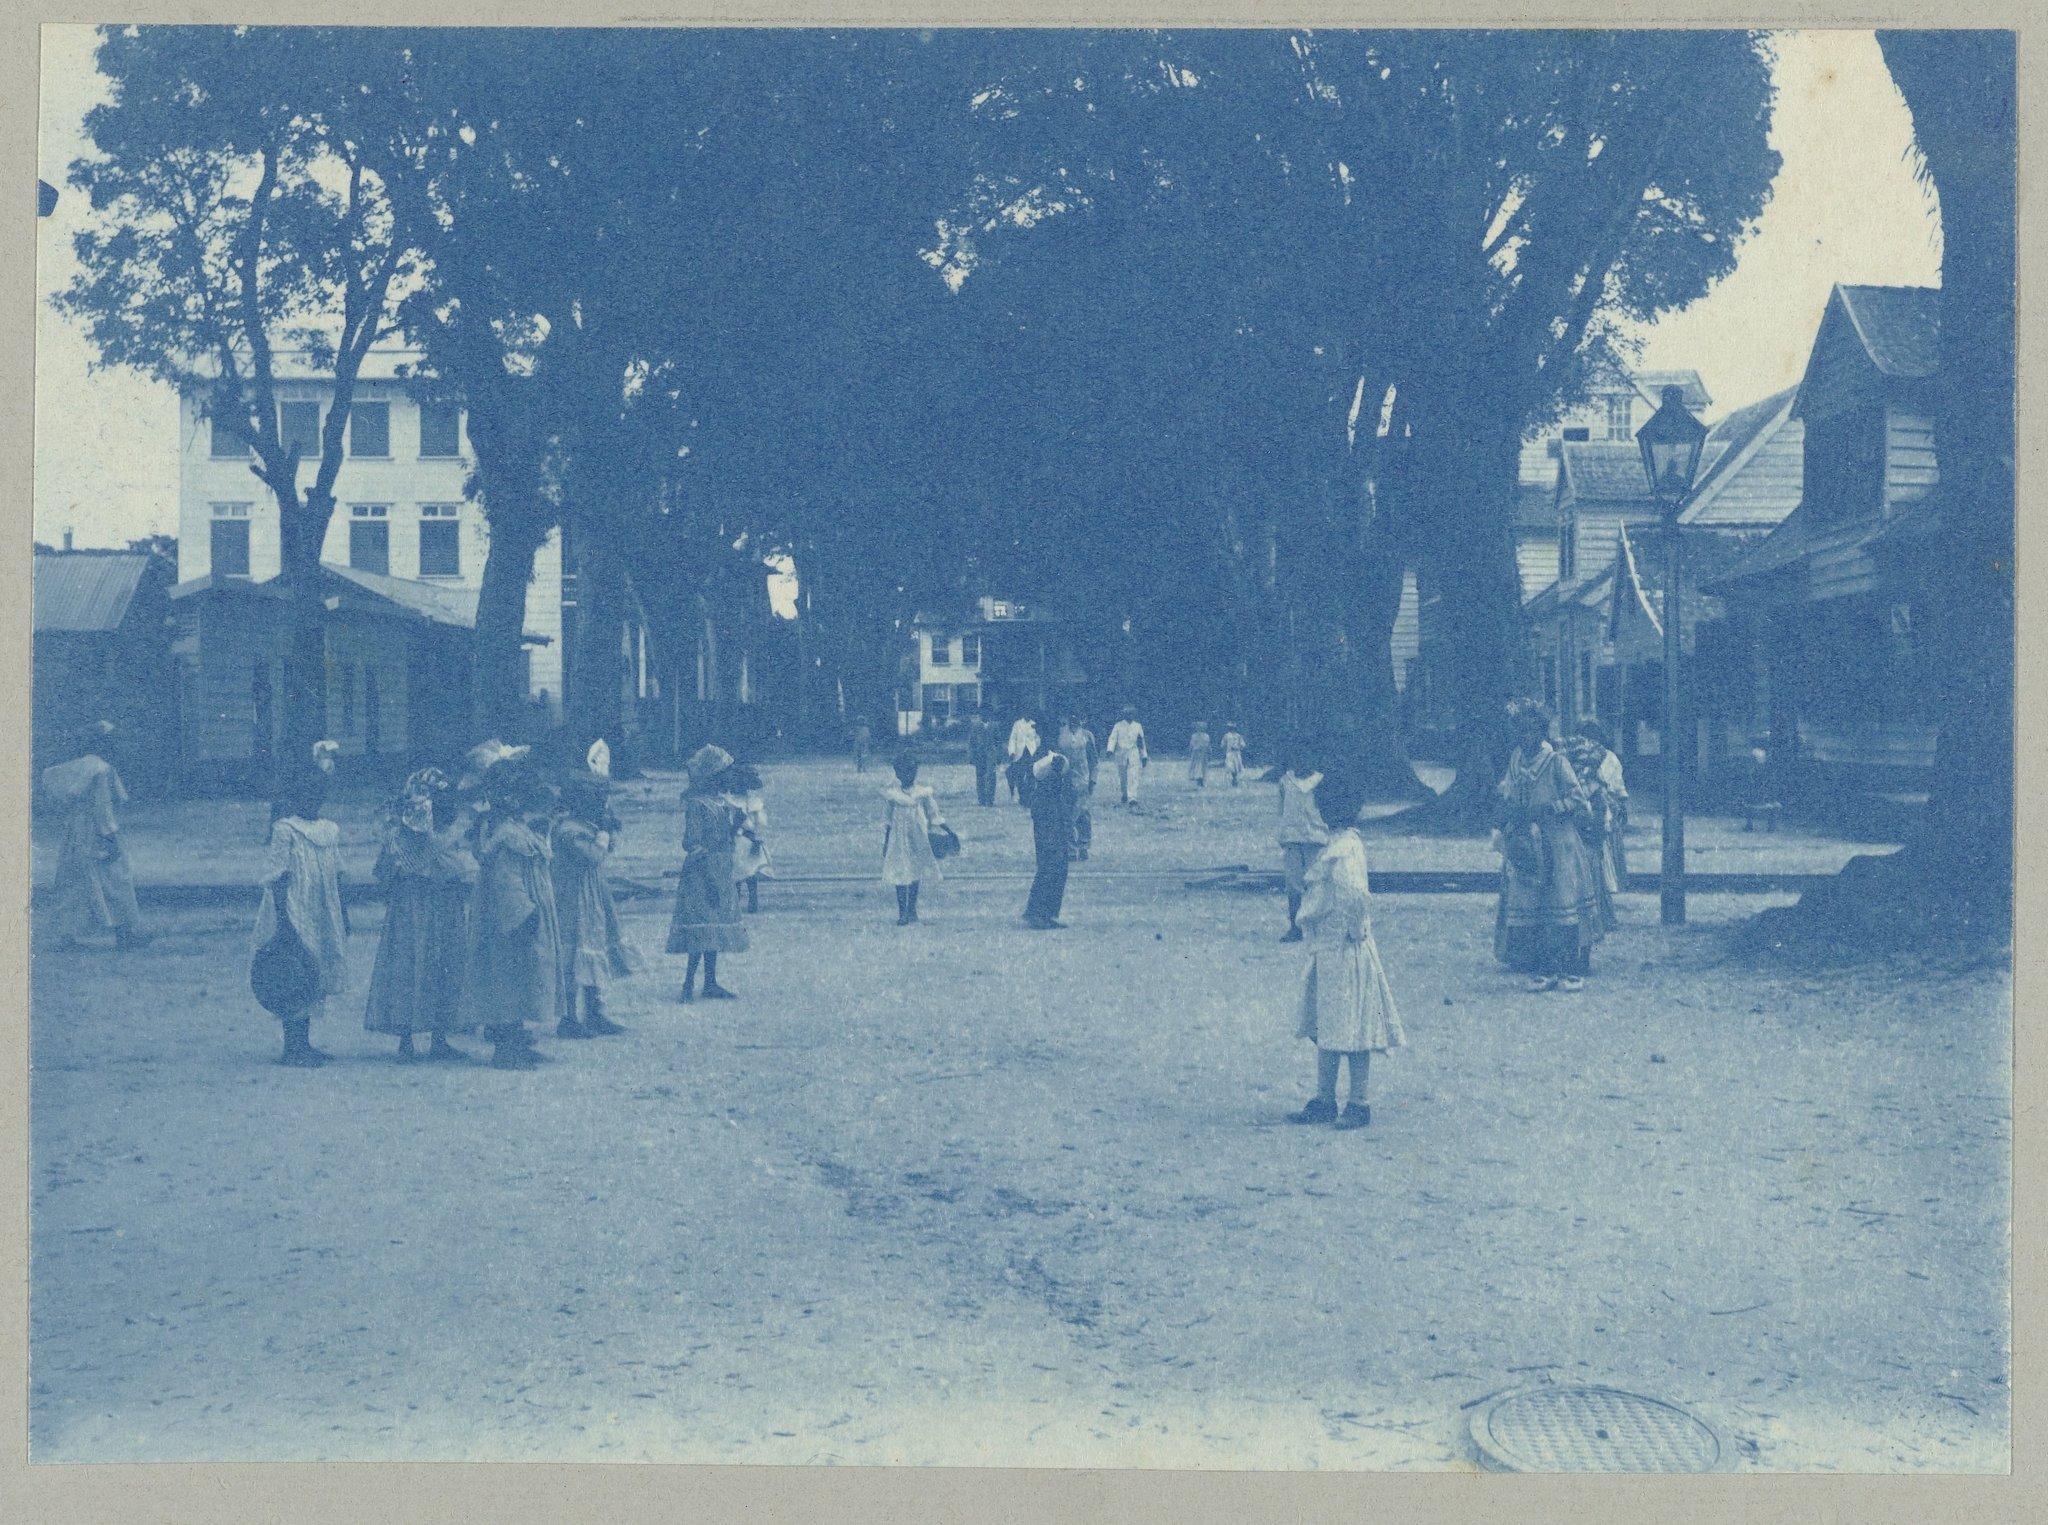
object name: photograph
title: Heerenstraat, Paramaribo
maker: hendrik doijer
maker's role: engineer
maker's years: 1863-1925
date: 1903-1910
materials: photographic support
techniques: cyanotype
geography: suriname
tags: suriname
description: Gezicht in de Heerenstraat te Paramaribo, op de voorgrond een groep meisjes. Onderdeel van het fotoalbum Souvenir de Voyage (deel 2), over het leven van de familie Doijer in en rond de plantage Ma Retraite in Suriname in de jaren 1903-1910.